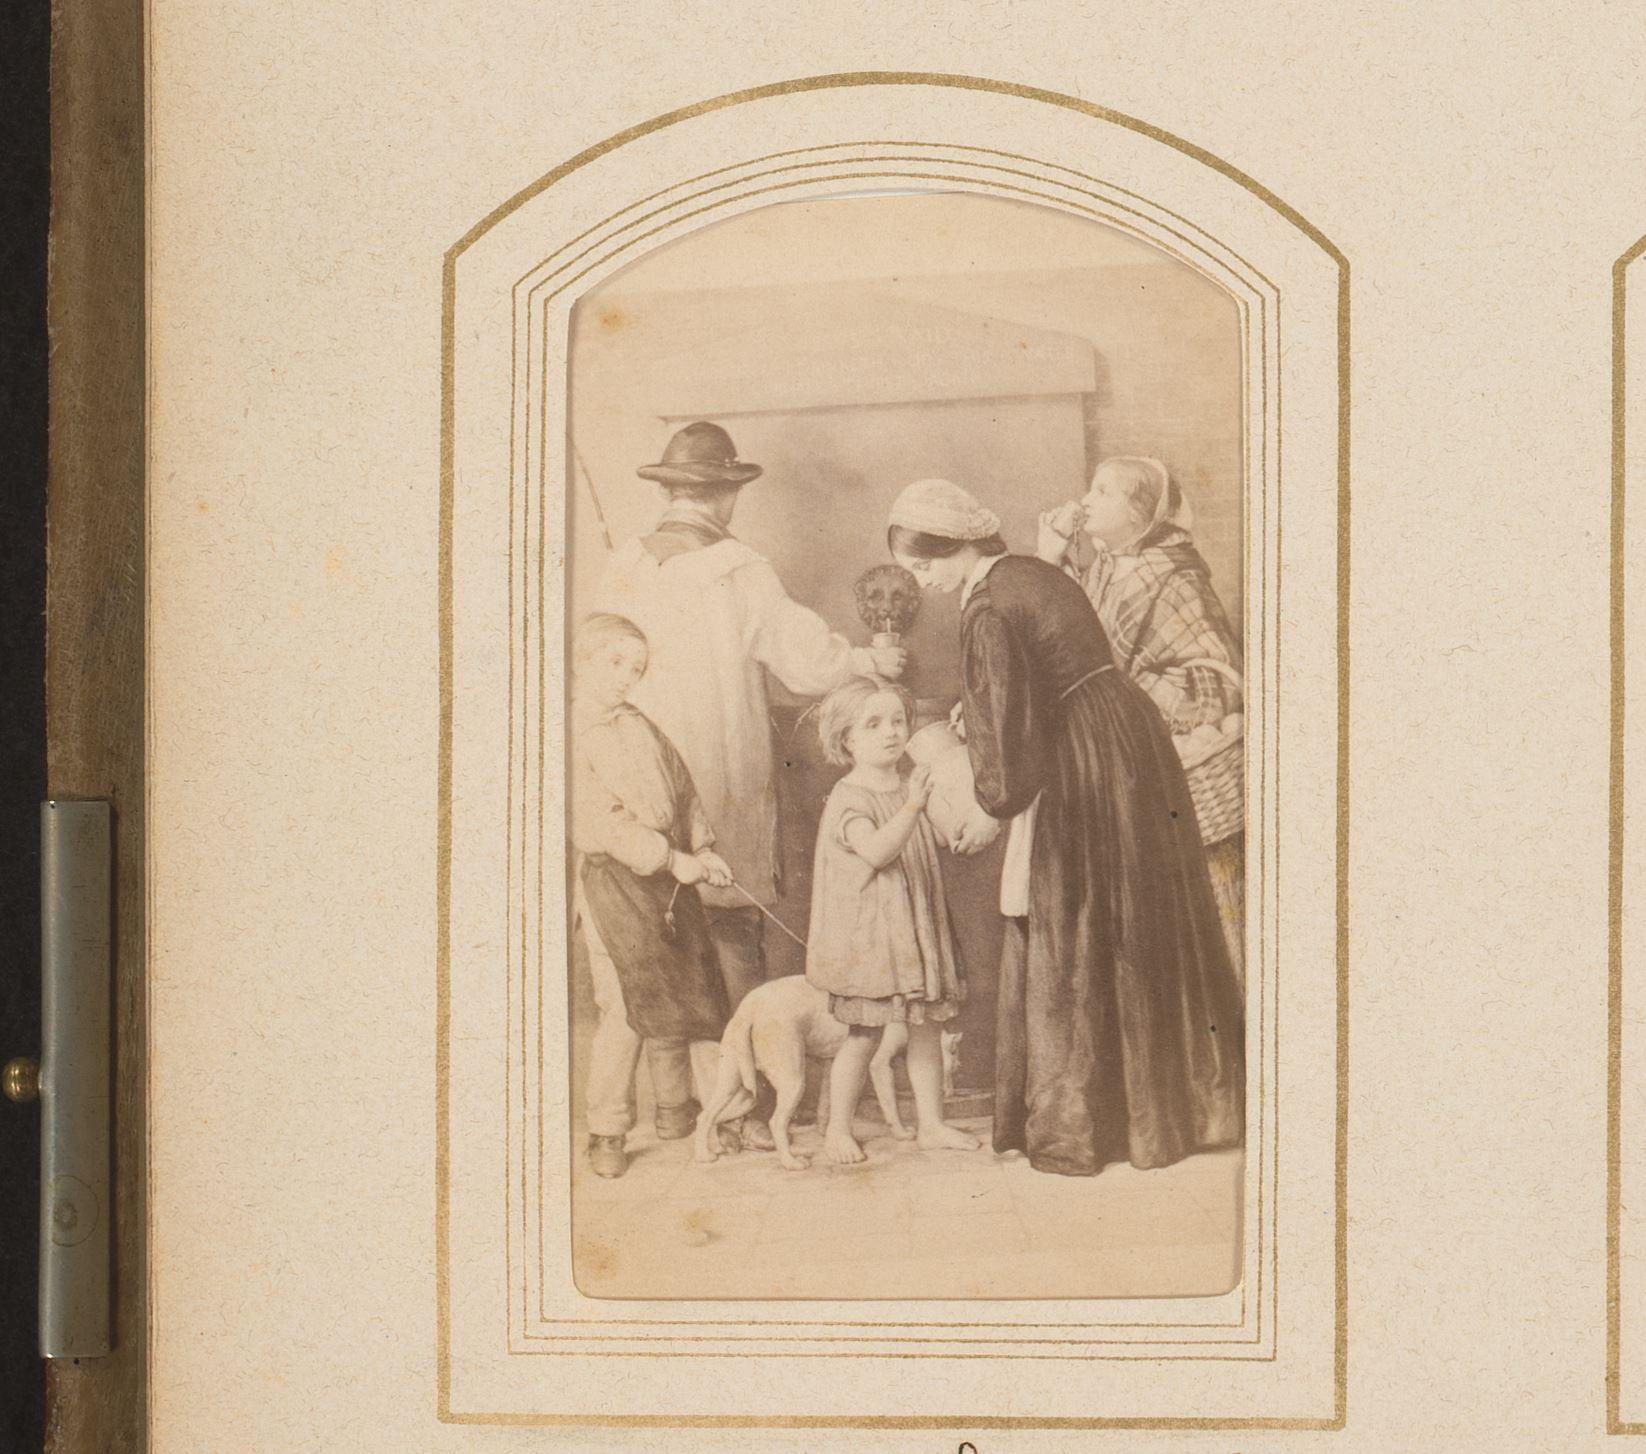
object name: reproduction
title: Fotoreproductie van An der Quelle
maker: Anonymous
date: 1870-1890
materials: cardboard, photographic support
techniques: albumen print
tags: utilitarian, public pump or water fountain, painting, drawing and the graphic arts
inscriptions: annotation: ‘An der Quelle’, inscription: ‘No. 2935./ A la fontaine/ In der Quelle/ At the fountain’